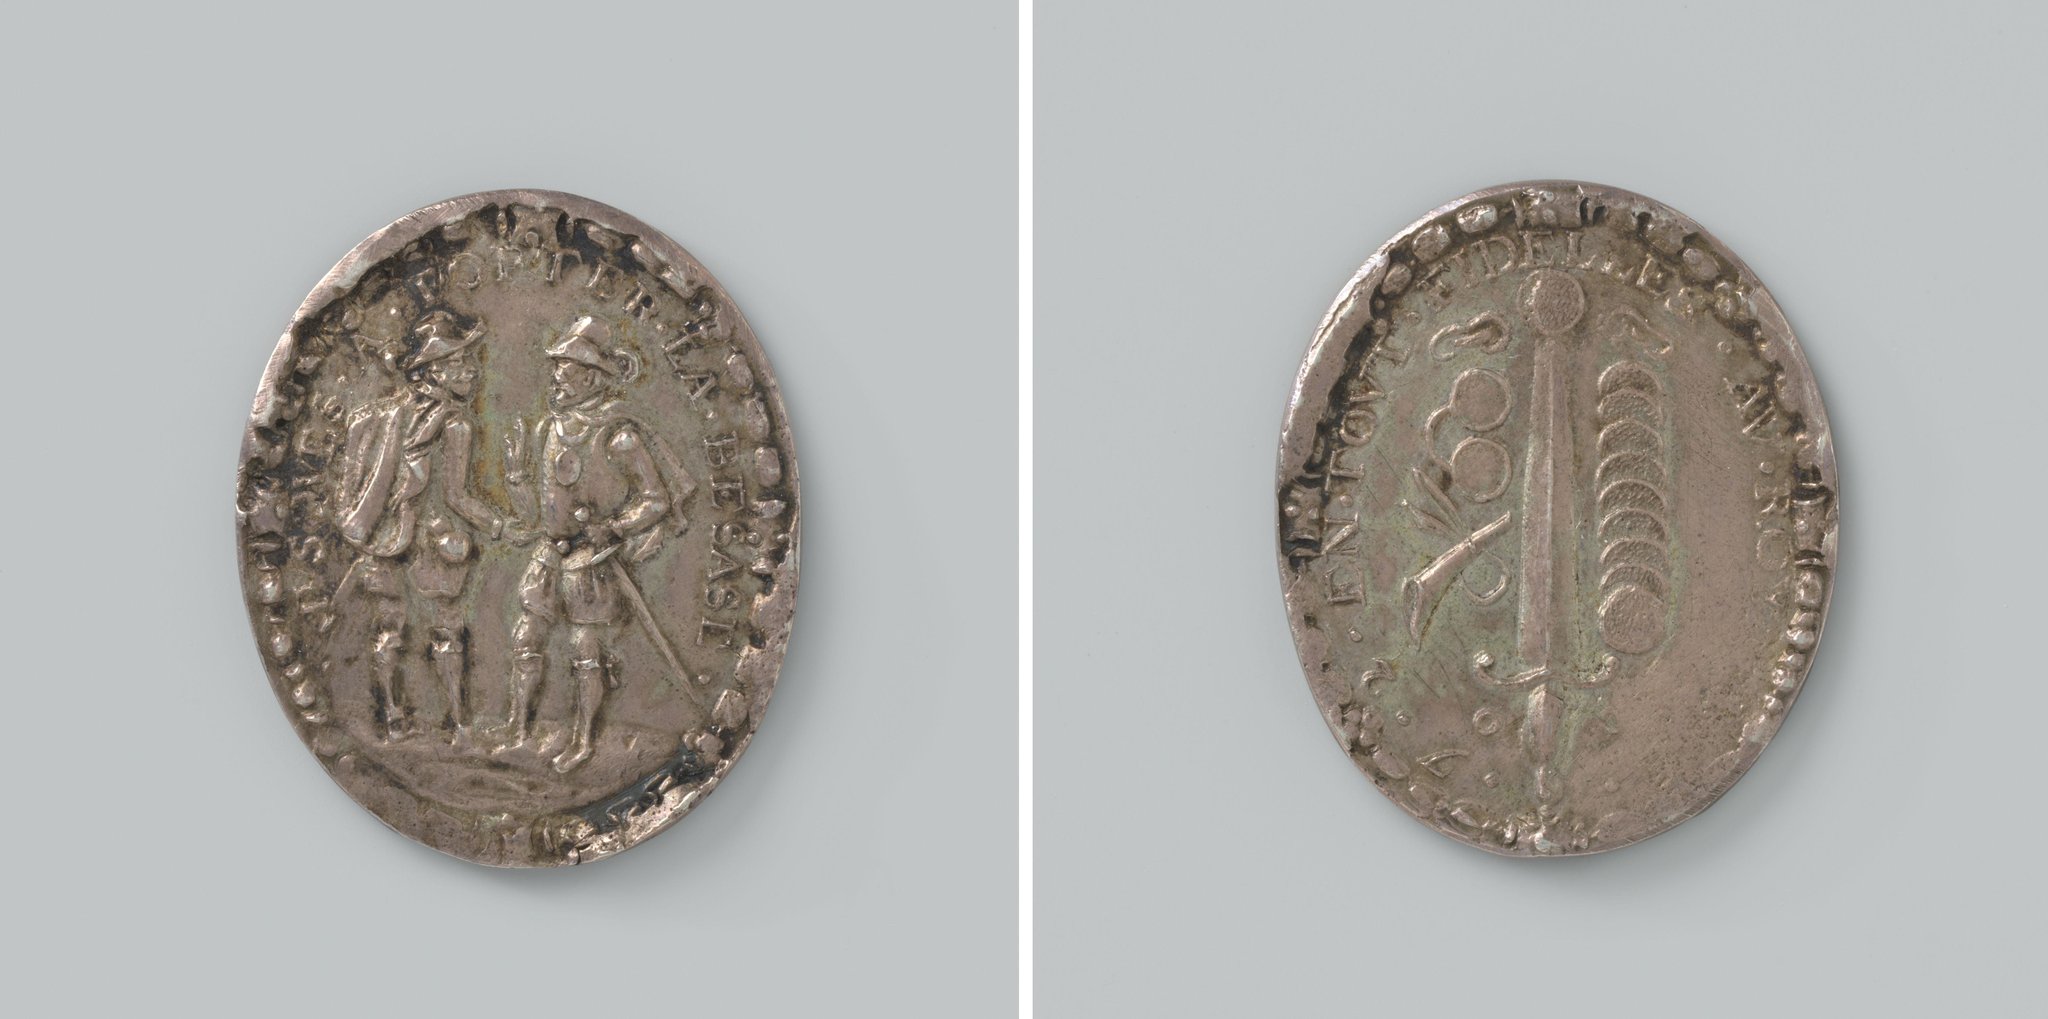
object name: beggar's medal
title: Geuzenpenning tegen de Tiende Penning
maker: Anonymous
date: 1572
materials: silver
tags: fernando álvarez de toledo (3rd duke of alba)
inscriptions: circumscription: ‘EN.TOVT.FIDELLES.AV.ROY [15] 72’, circumscription: ‘IVSQVES.A.PORTER.LA.BESACE’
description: gemaakt vanwege de inname van Den Briel, zichtpenning [opmerking schenker]